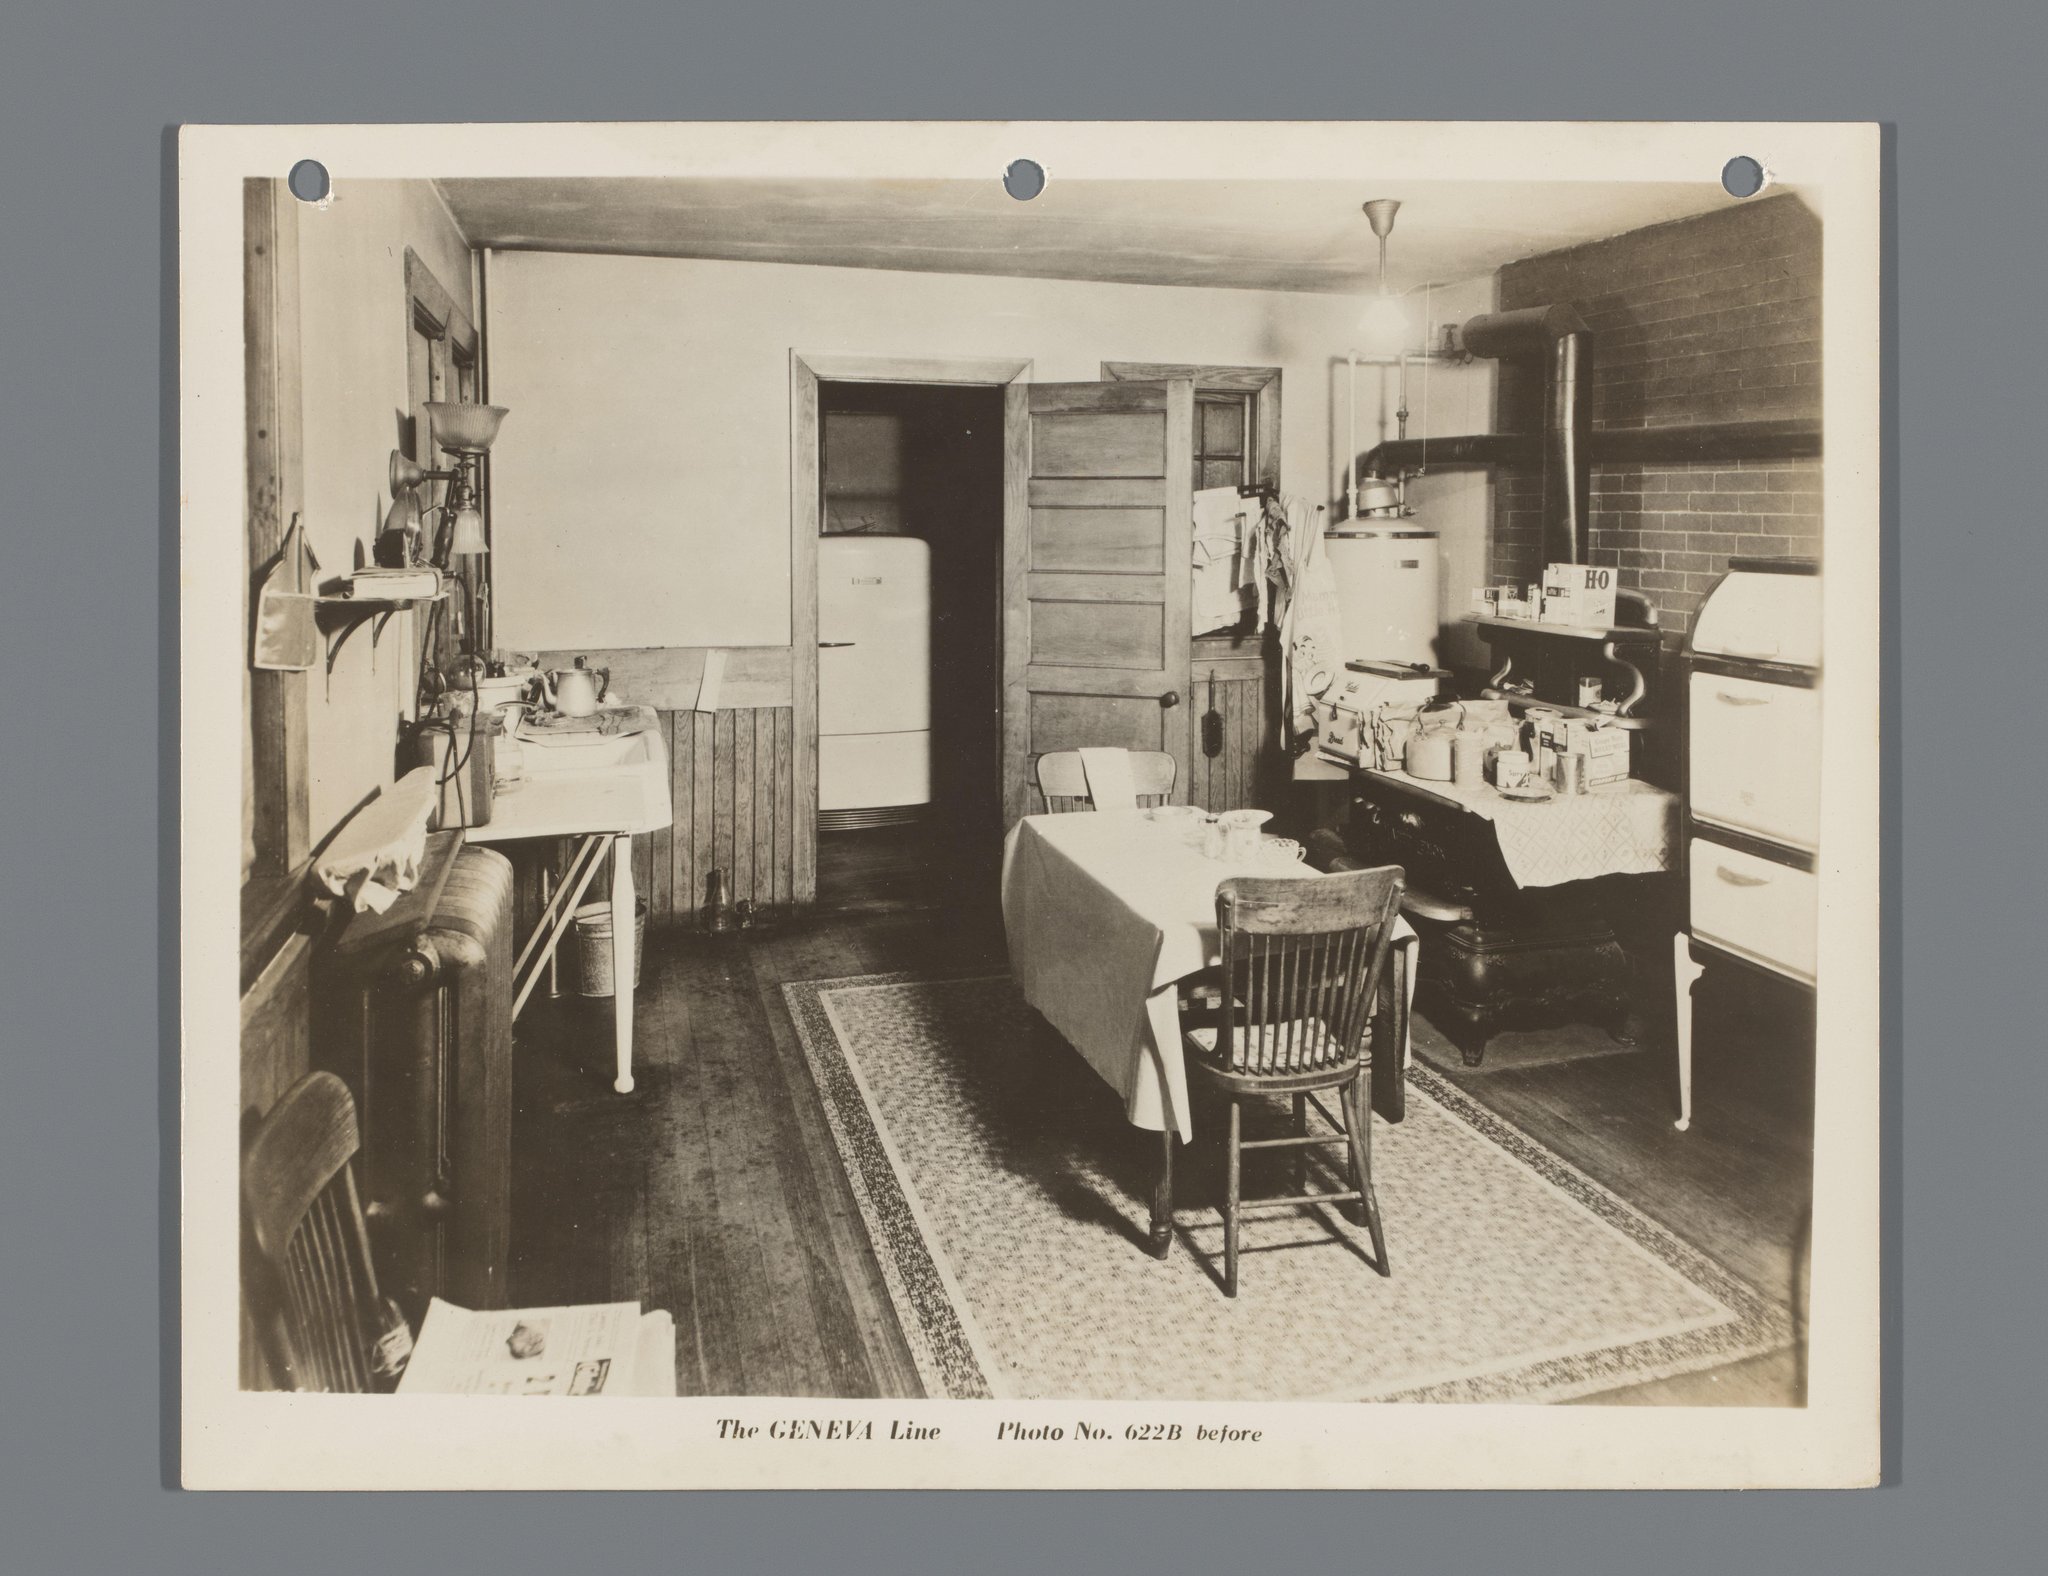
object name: photograph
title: Keuken Geneva Line, before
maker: Anonymous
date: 1920-1930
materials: photographic support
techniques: gelatin silver print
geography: united states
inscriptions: inscription: ‘The GENEVA Line Photo No. 622B before’